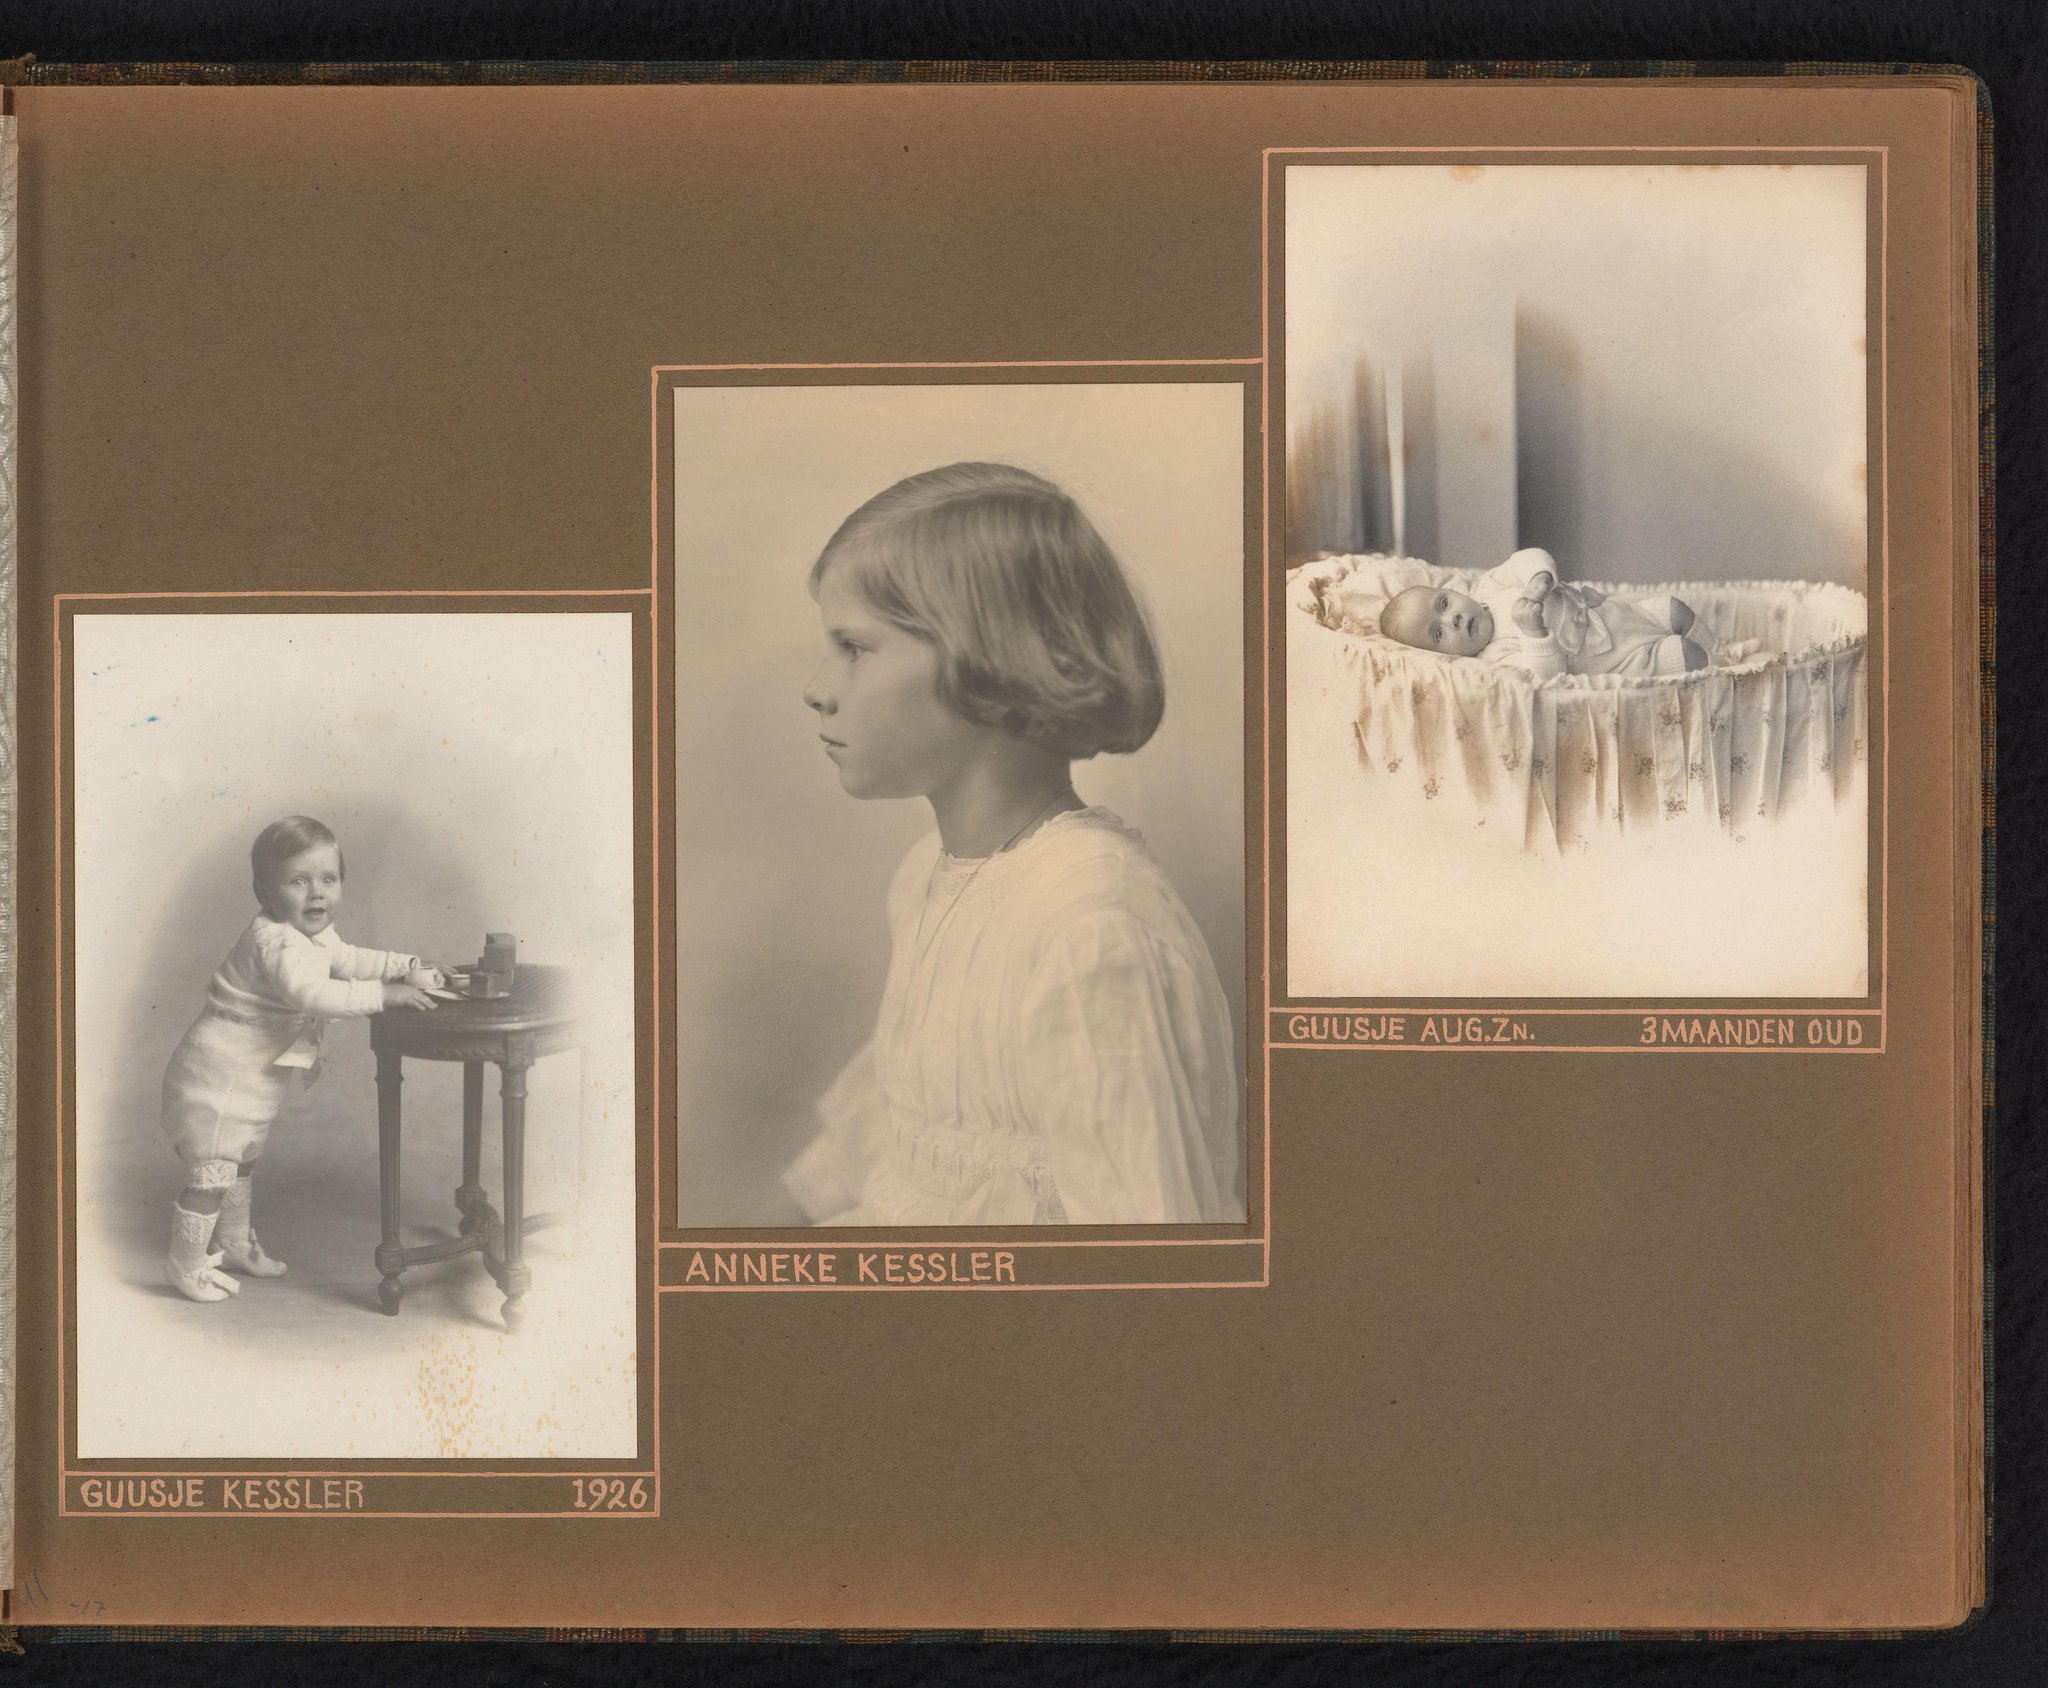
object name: album leaf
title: Portretten van Anneke en Guus Kessler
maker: Anonymous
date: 1925-1926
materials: paper, cardboard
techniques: gelatin silver print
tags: historical persons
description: Deze foto's zijn onderdeel van een album.